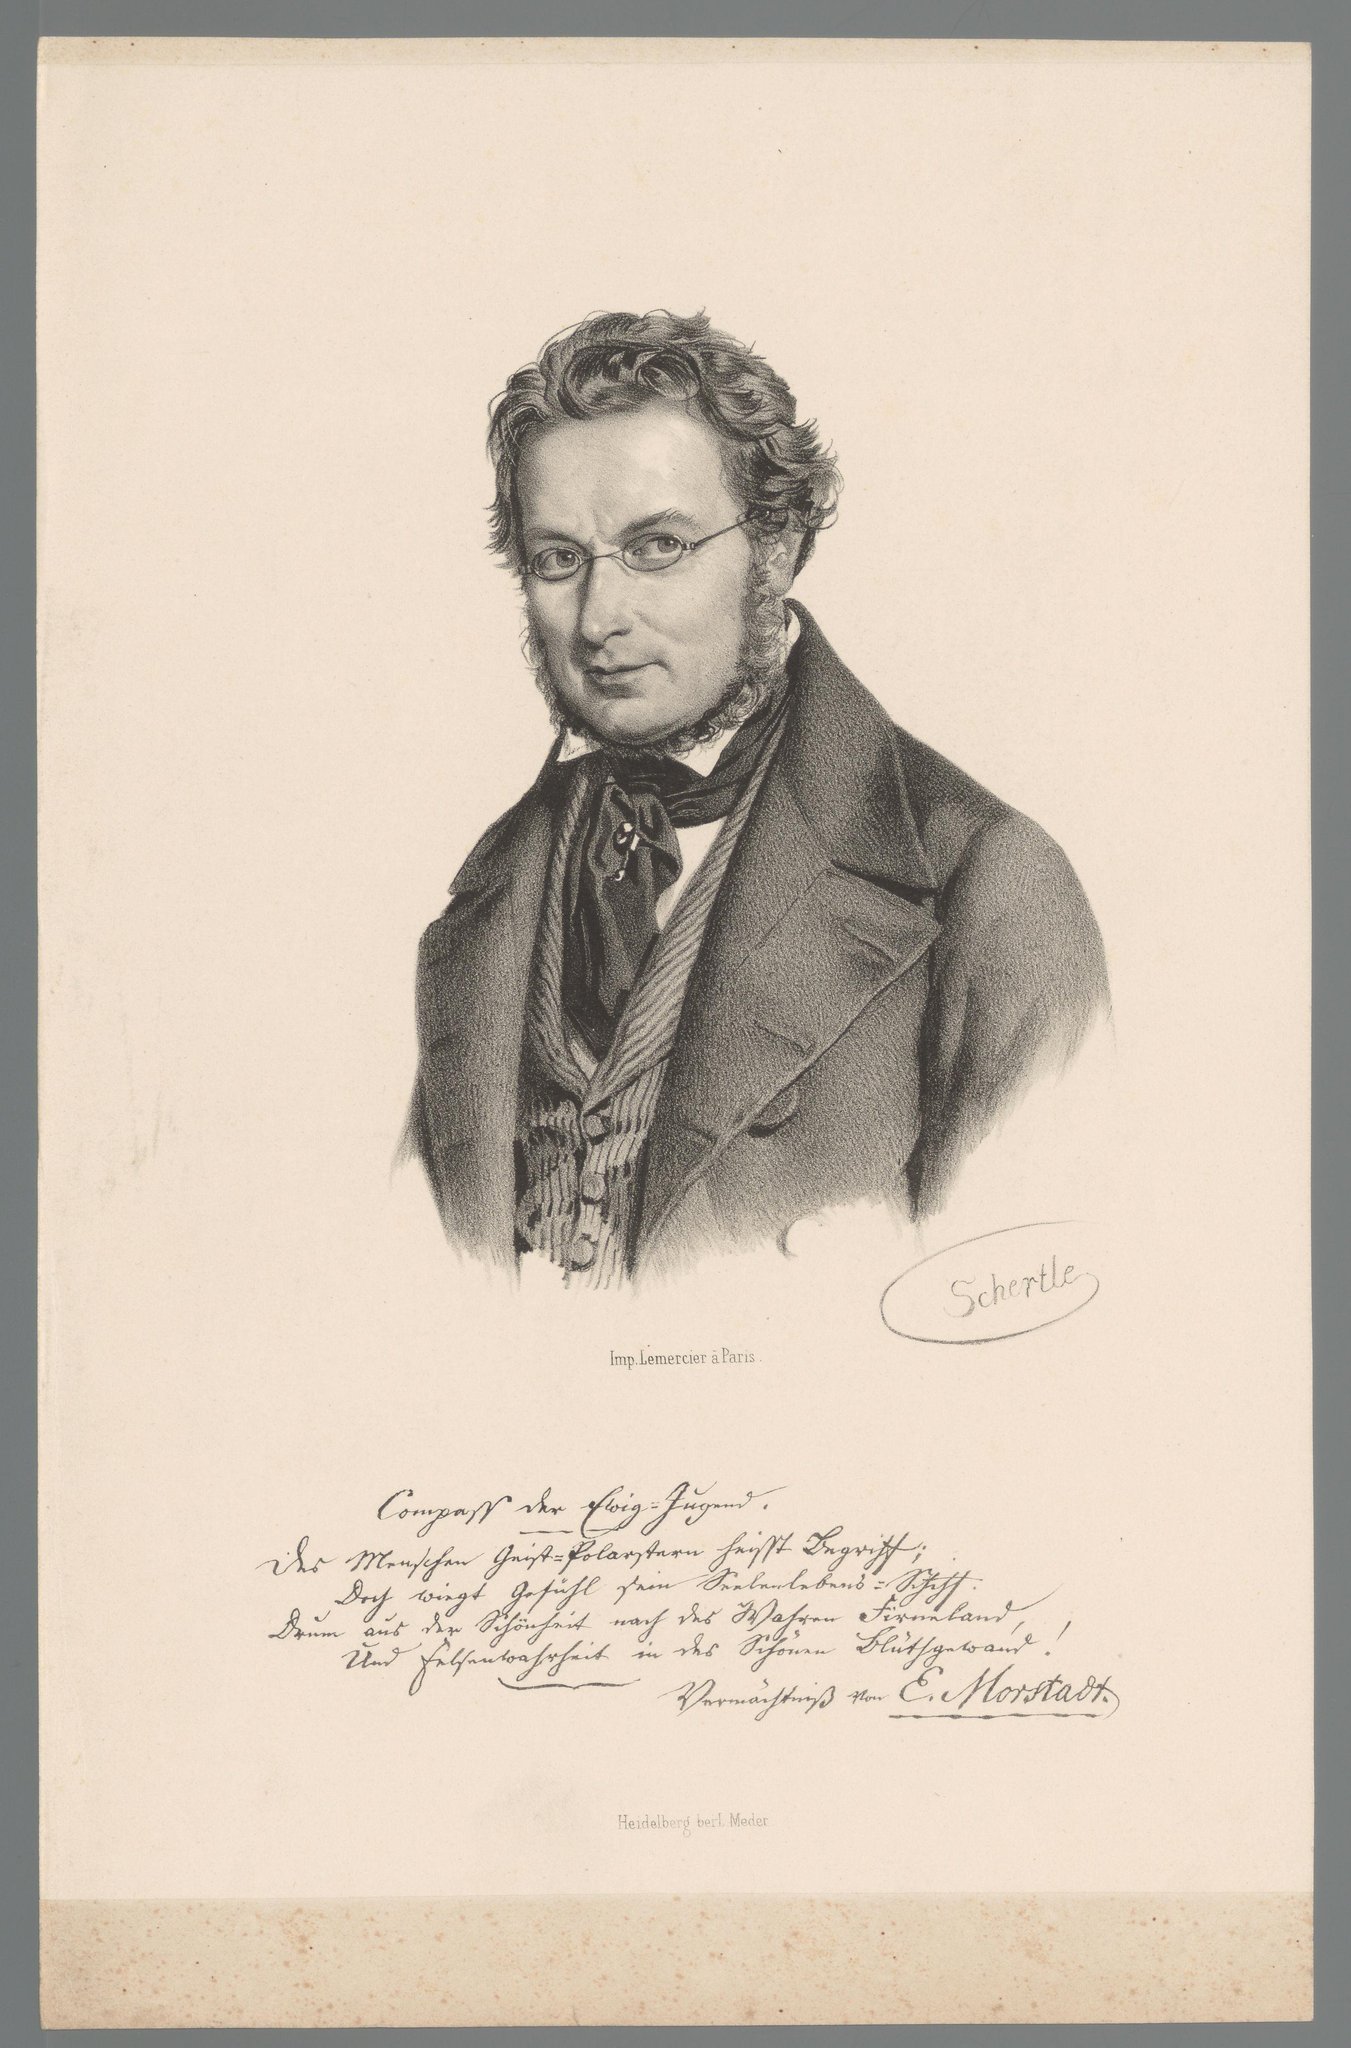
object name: print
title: Portret van Carl Eduard Morstadt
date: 1819-1885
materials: paper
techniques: lithograph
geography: paris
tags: eyeglasses, spectacles, adult man, historical persons, beard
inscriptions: collector's mark: Lugt 2228